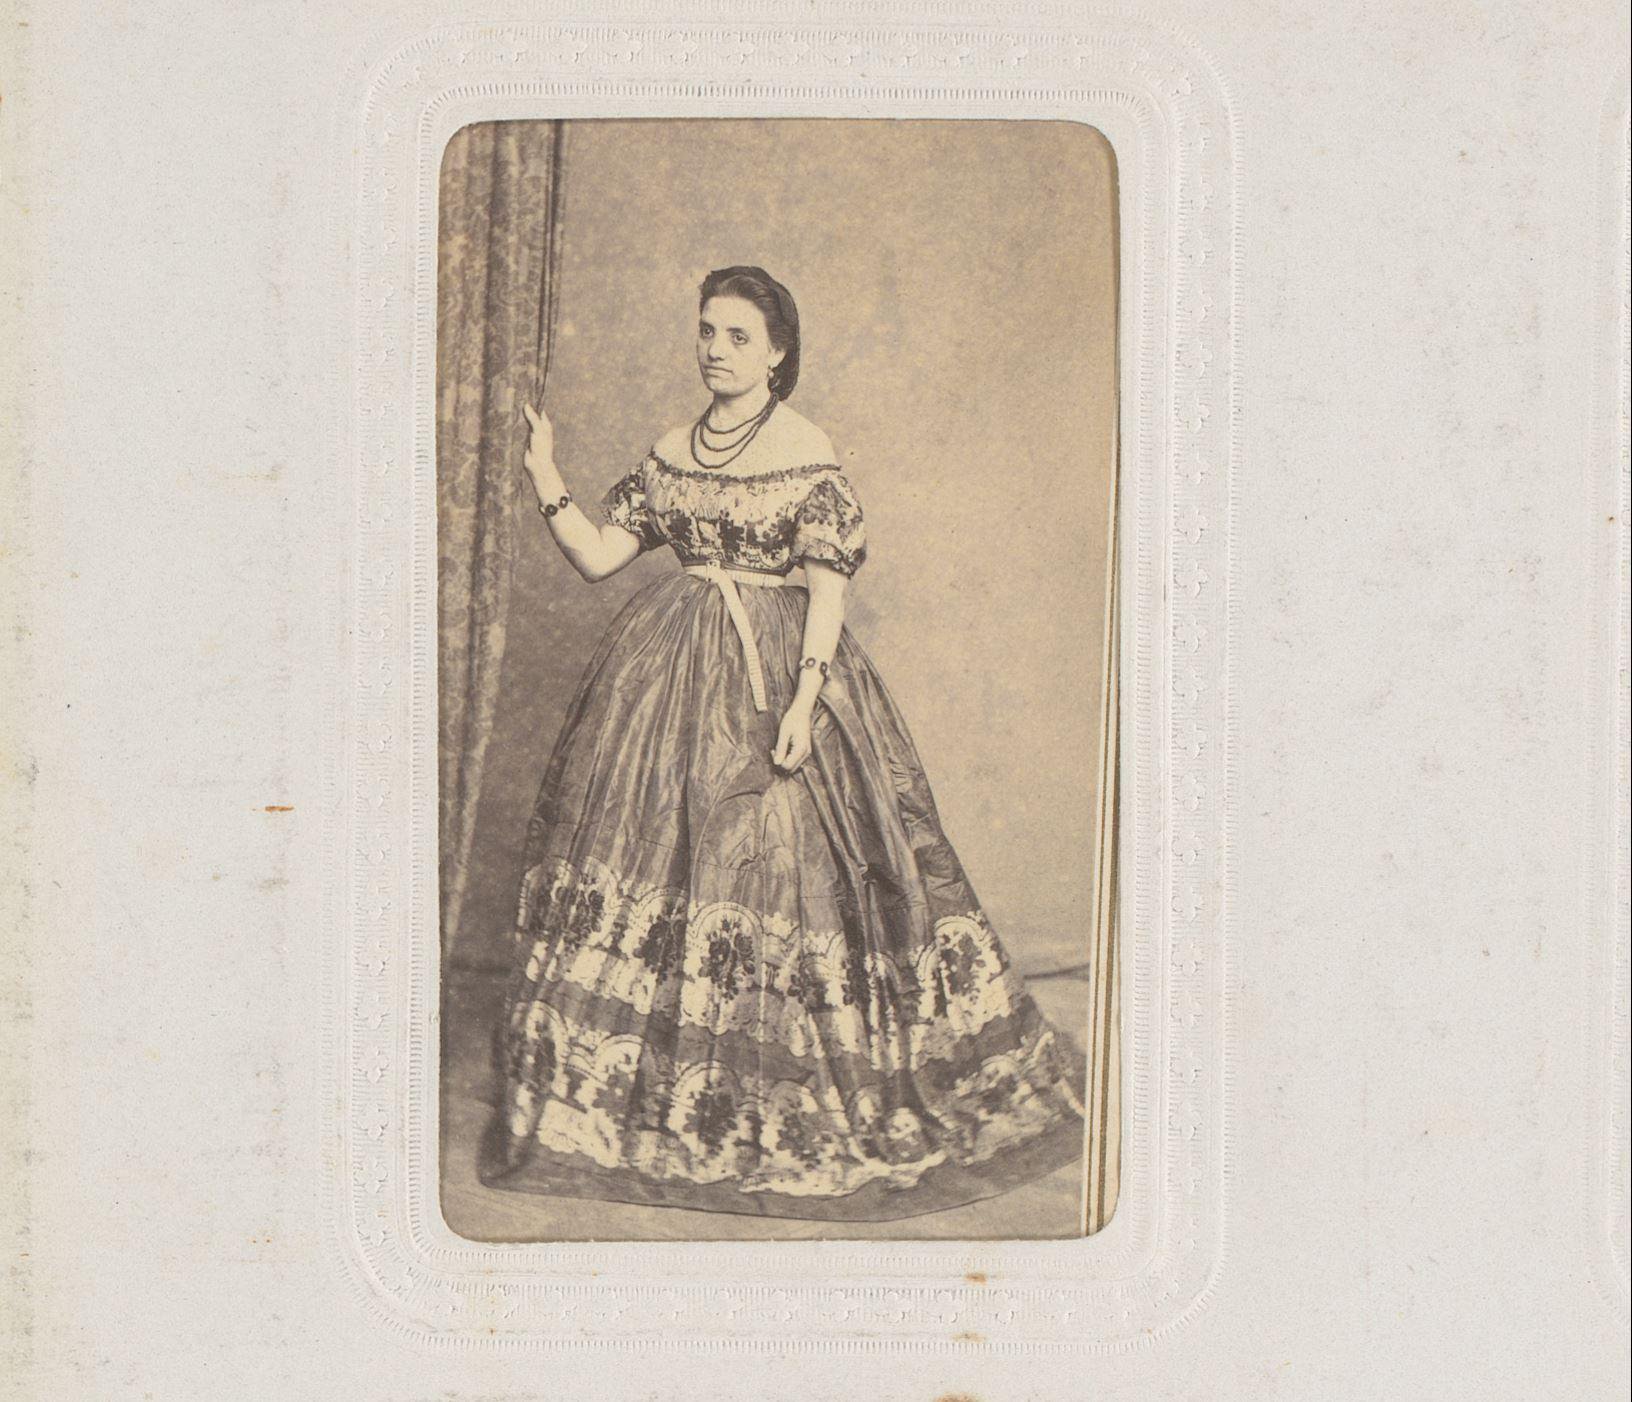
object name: album leaf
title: Portret van een vrouw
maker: Anonymous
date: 1860-1890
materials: cardboard, photographic support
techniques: albumen print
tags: historical persons - bb - woman